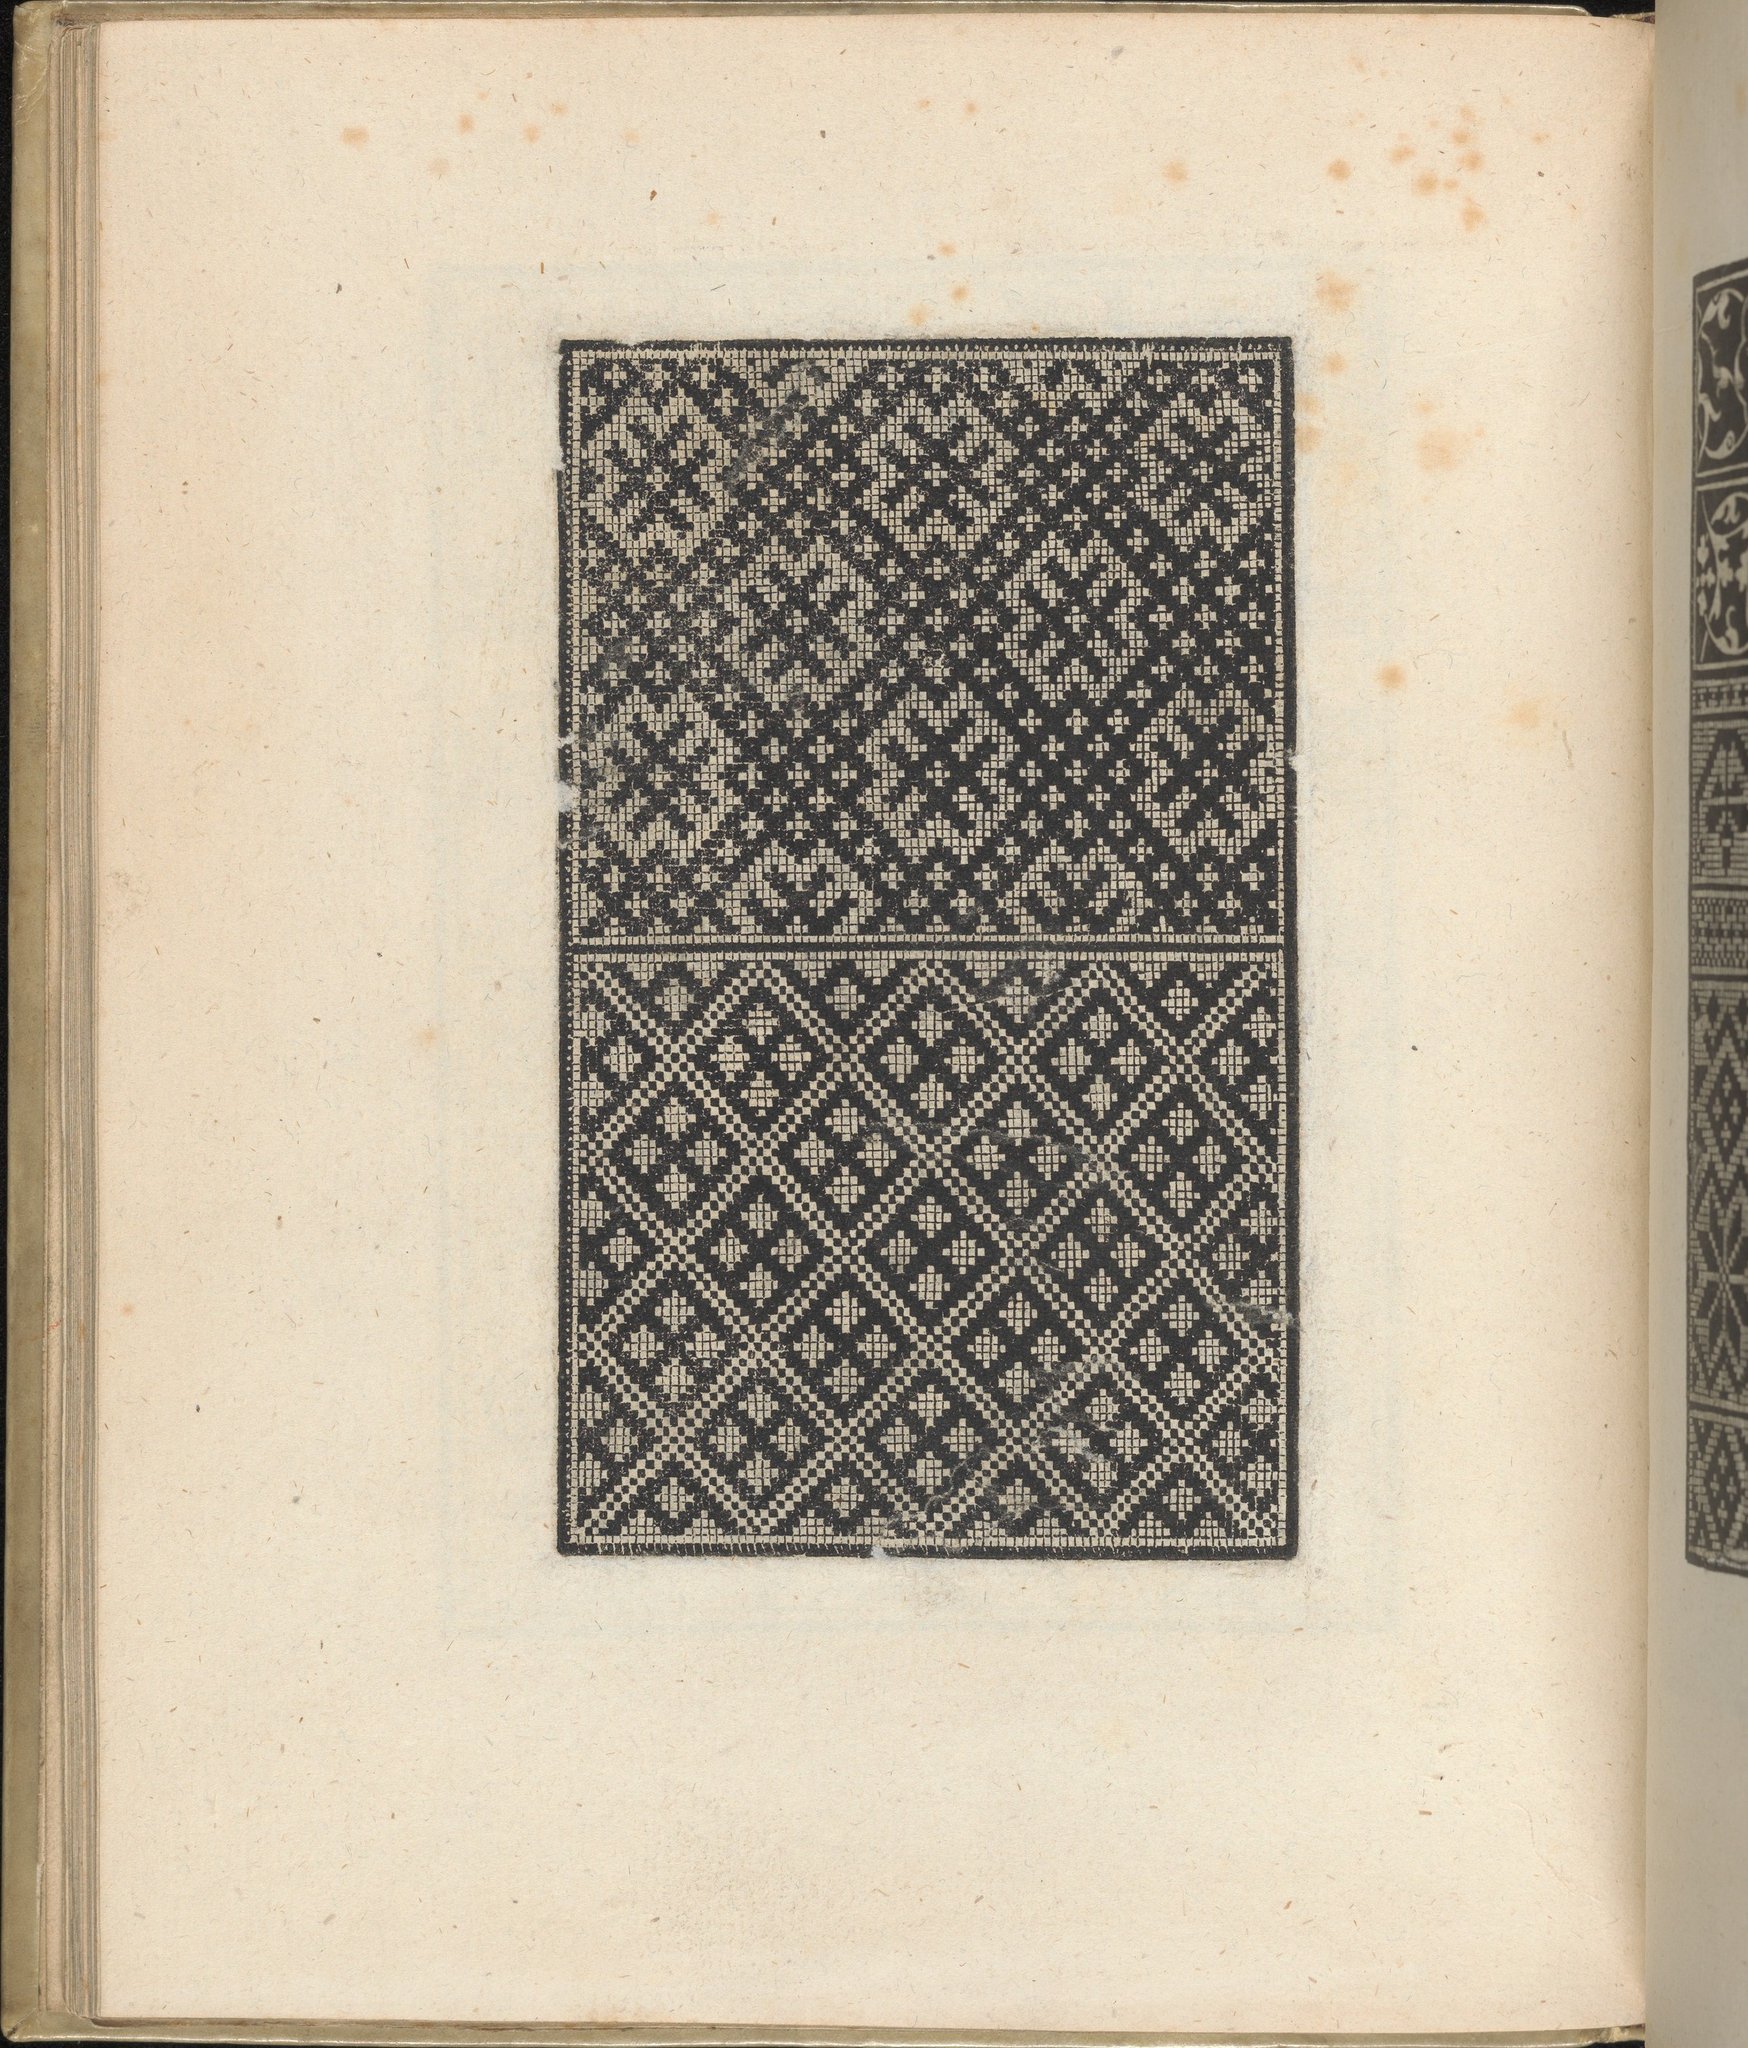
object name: book print ornament architecture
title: Trionfo Di Virtu. Libro Novo..., page 25 (recto)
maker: matteo pagano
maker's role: publisher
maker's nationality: italian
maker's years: 1515-1588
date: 1563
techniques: woodcut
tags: ornament